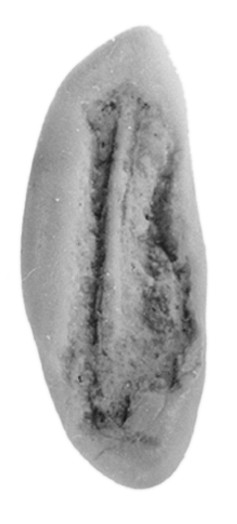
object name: sealing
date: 2030-1640 BCE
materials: clay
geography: egypt